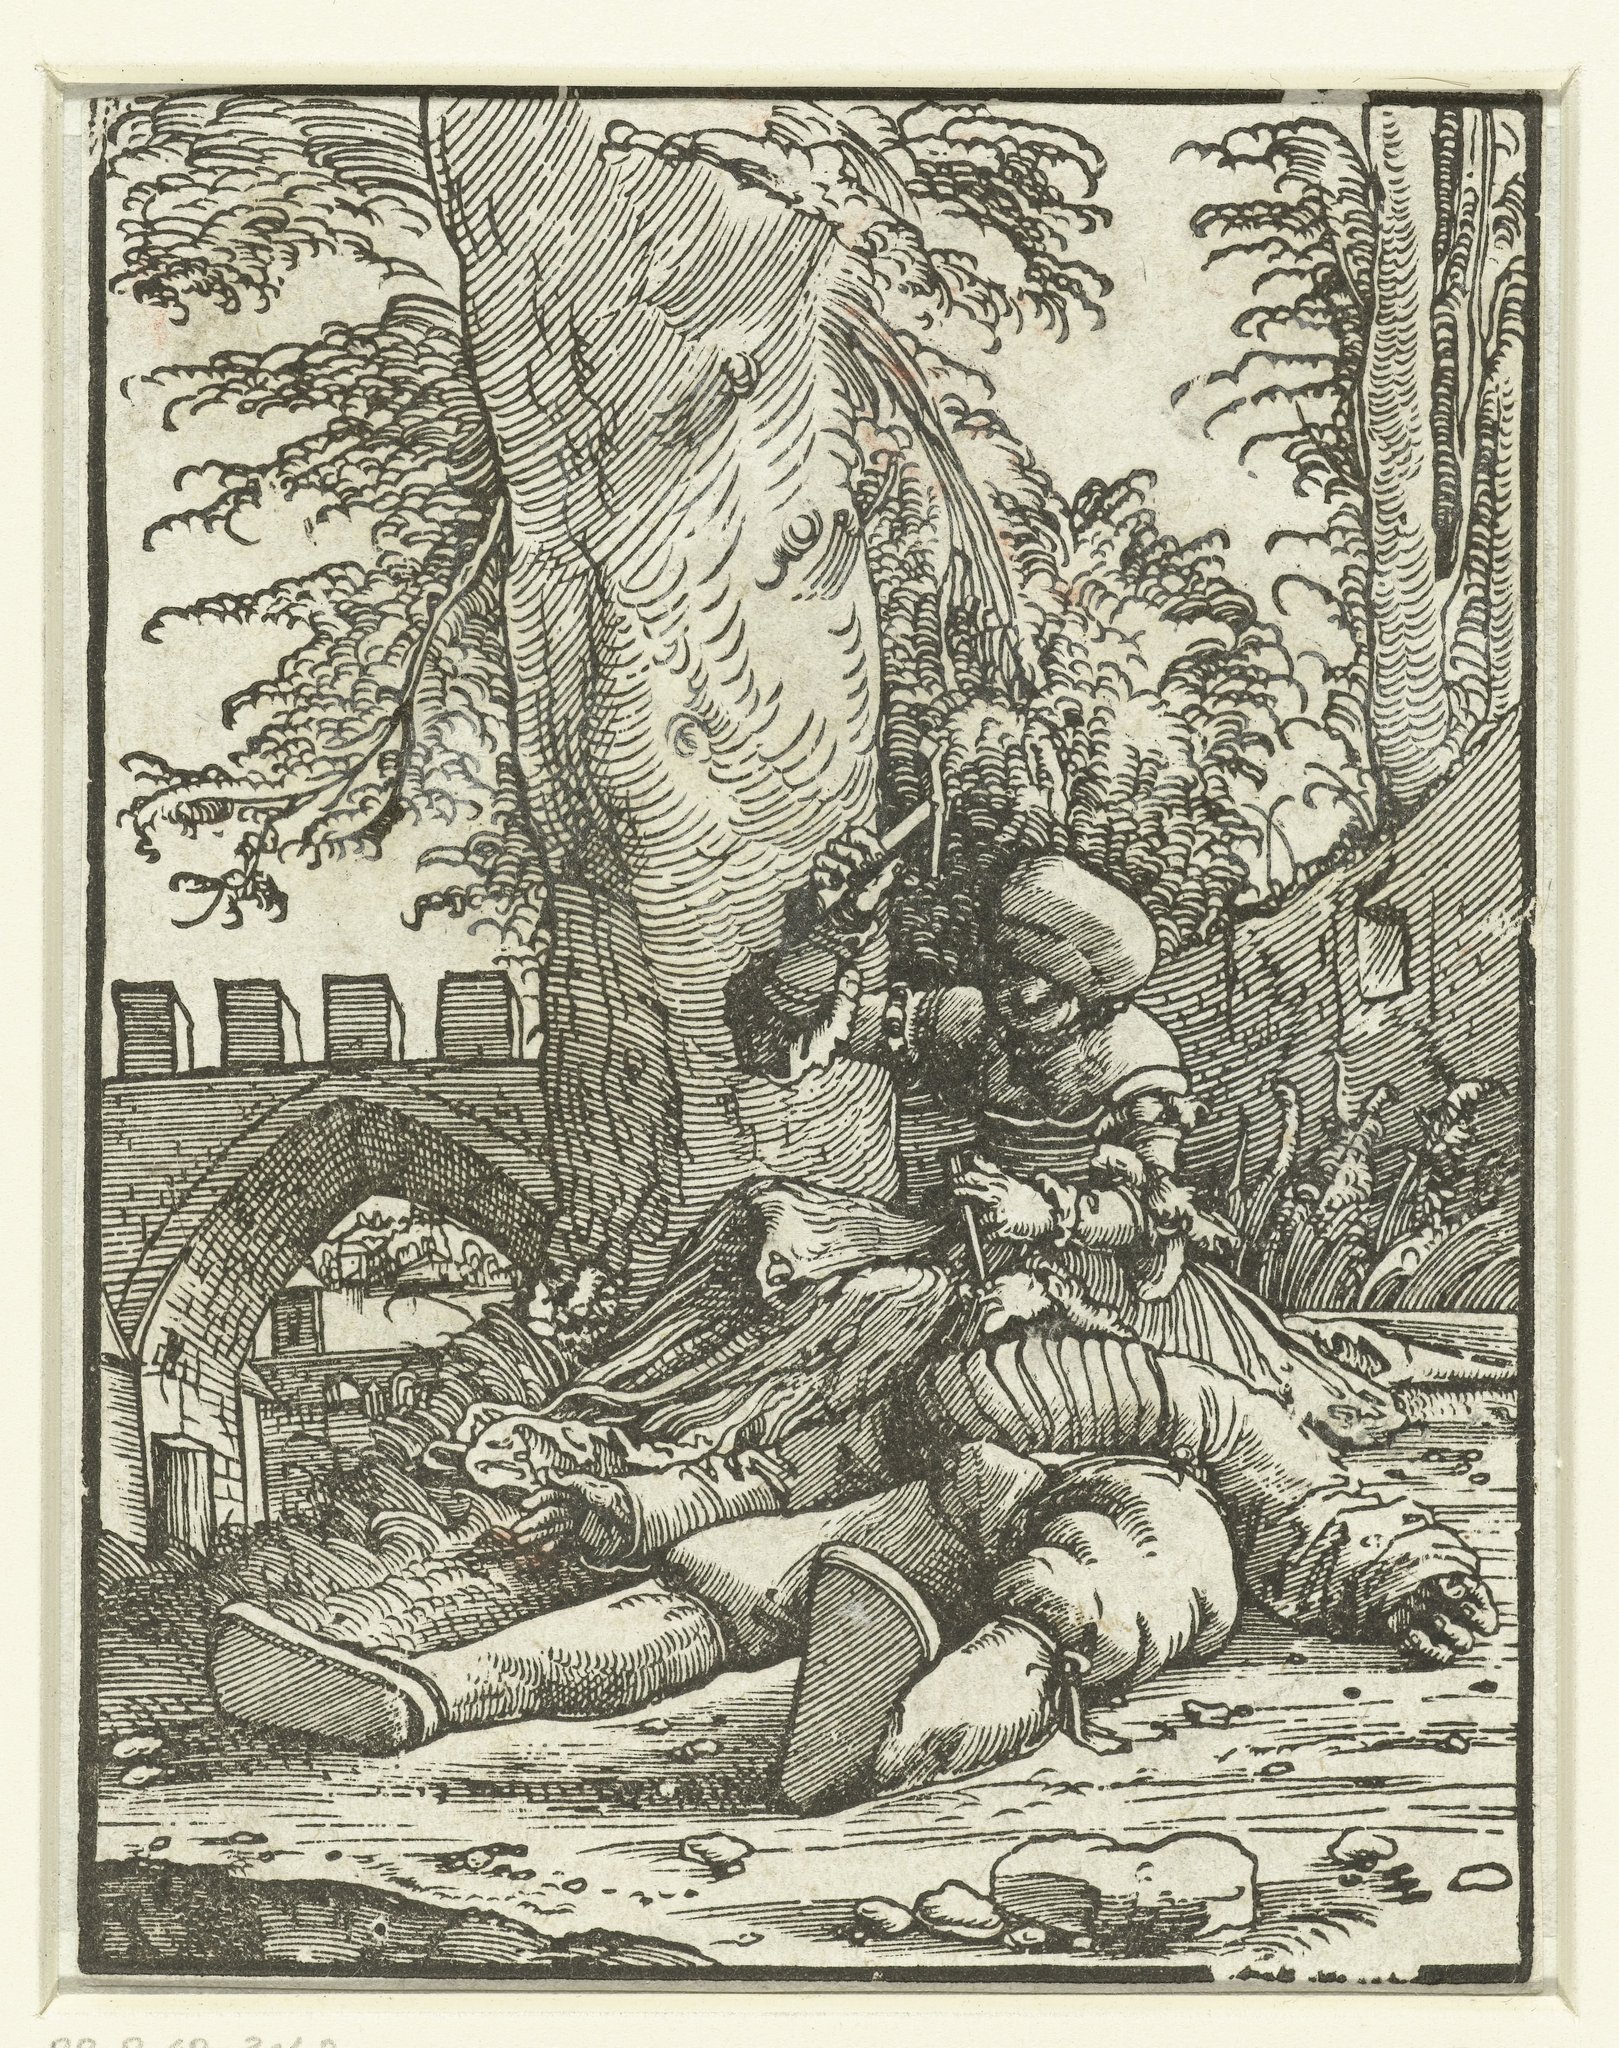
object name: print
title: Jaël doodt Sisera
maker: albrecht altdorfer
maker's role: draughtsman, print maker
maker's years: 1480-1538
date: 1506-1538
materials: paper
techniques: woodcut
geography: germany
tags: jael kills the sleeping sisera by hitting the nail through his temples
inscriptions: number: ‘72’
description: De legerleider Sisera, liggend op de grond in een diep slaap. Achter hem zit Jaël, zij staat op het punt hem te doden. Met haar linkerhand houdt zij een tentpin tegen het hoofd van Sisera, in haar andere hand heeft zij een hamer.